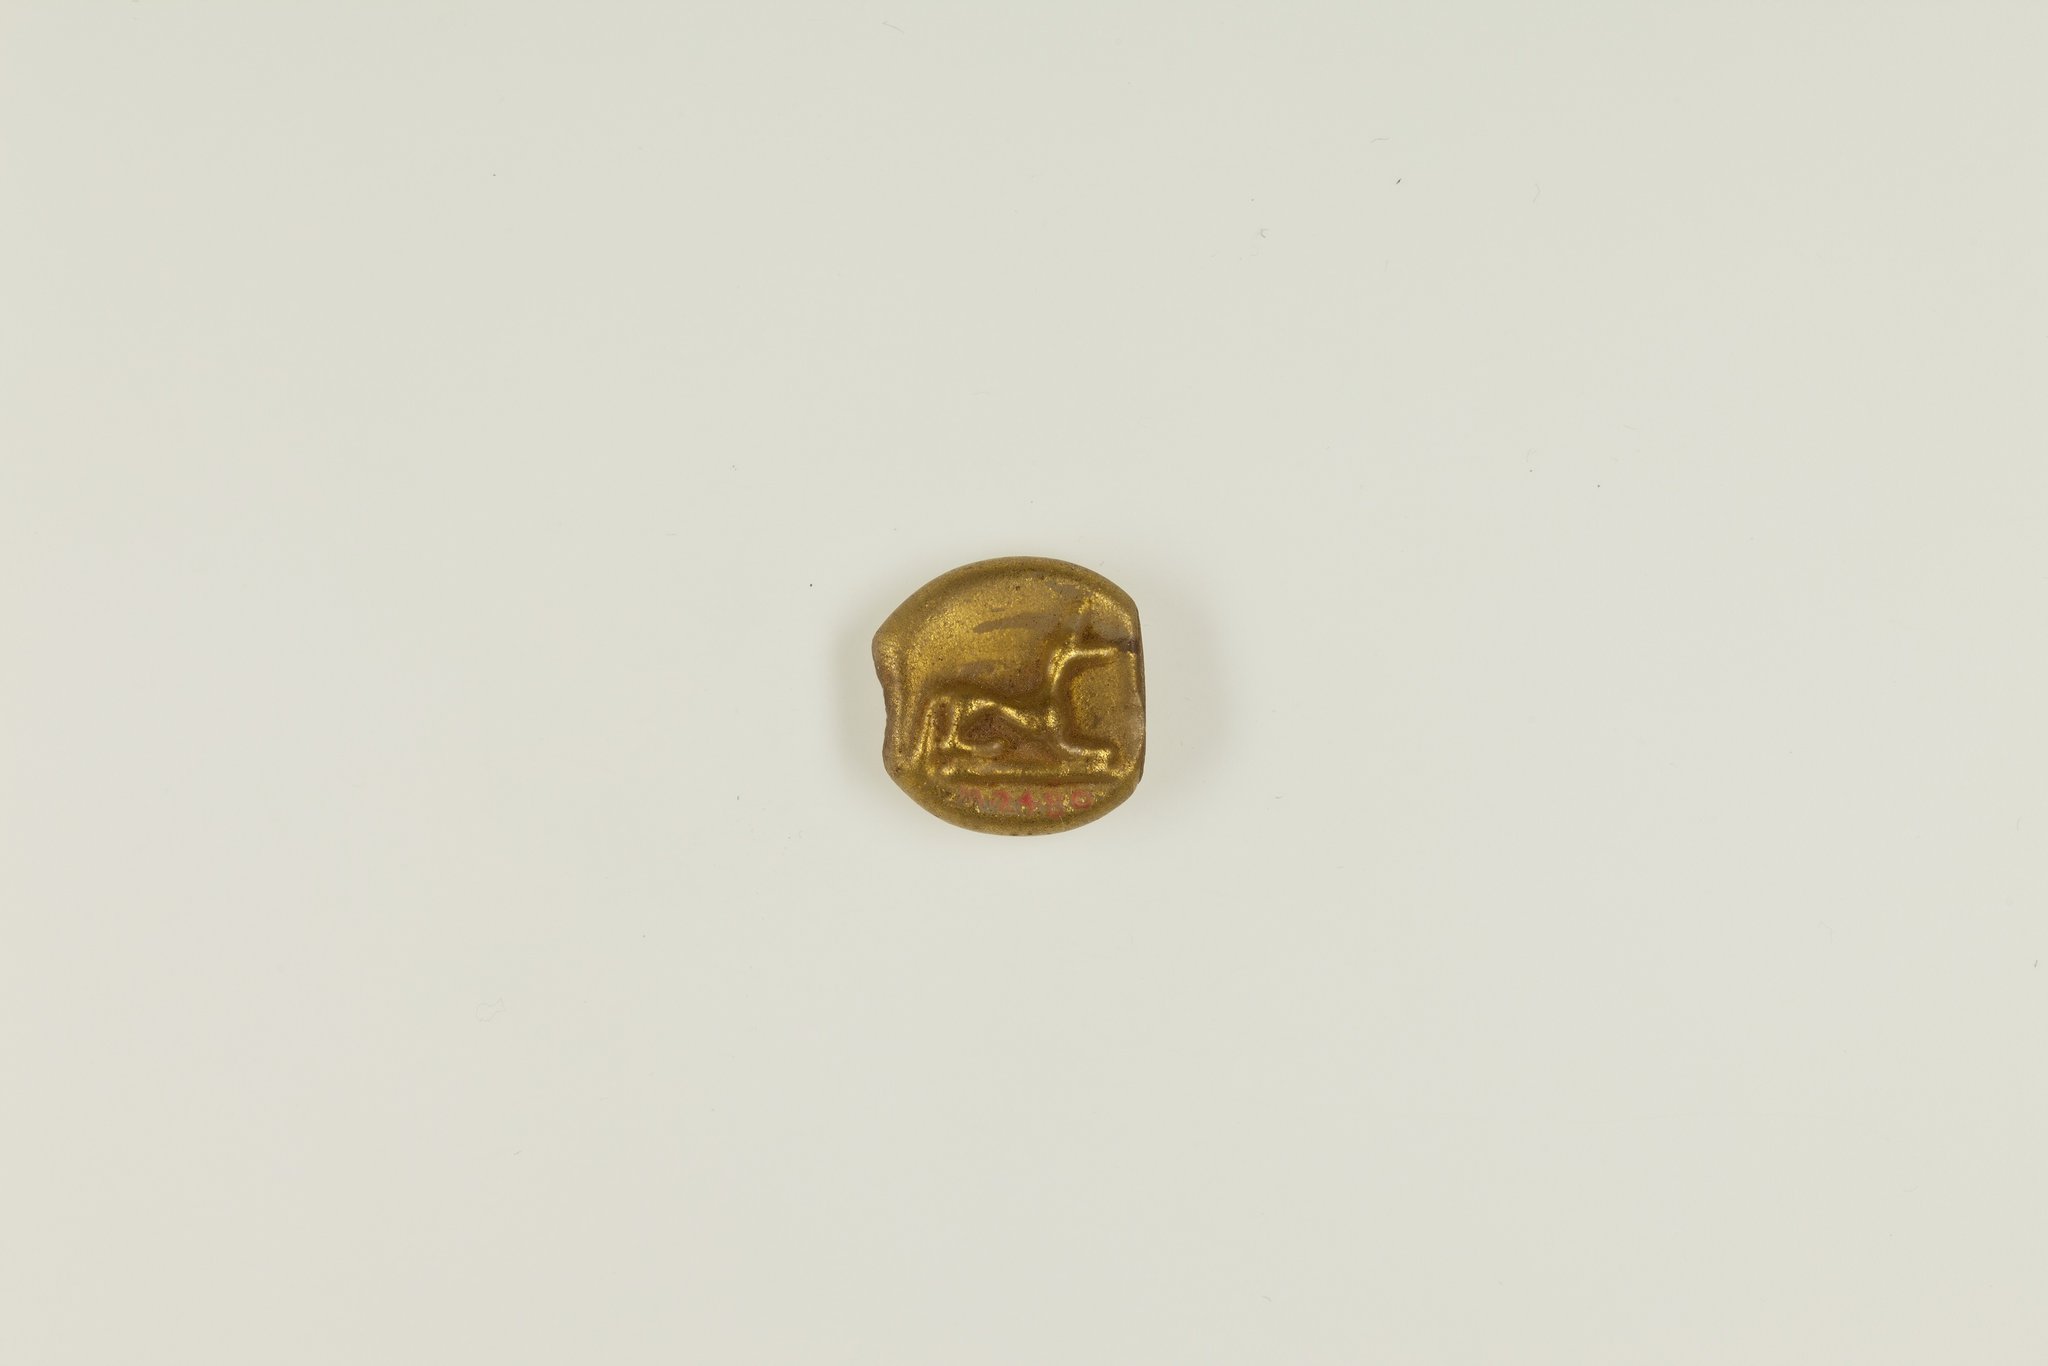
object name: bead amulet, jackal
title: Bead with a jackal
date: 100 BCE-100 CE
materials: glass, gold foil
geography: egypt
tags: jackals